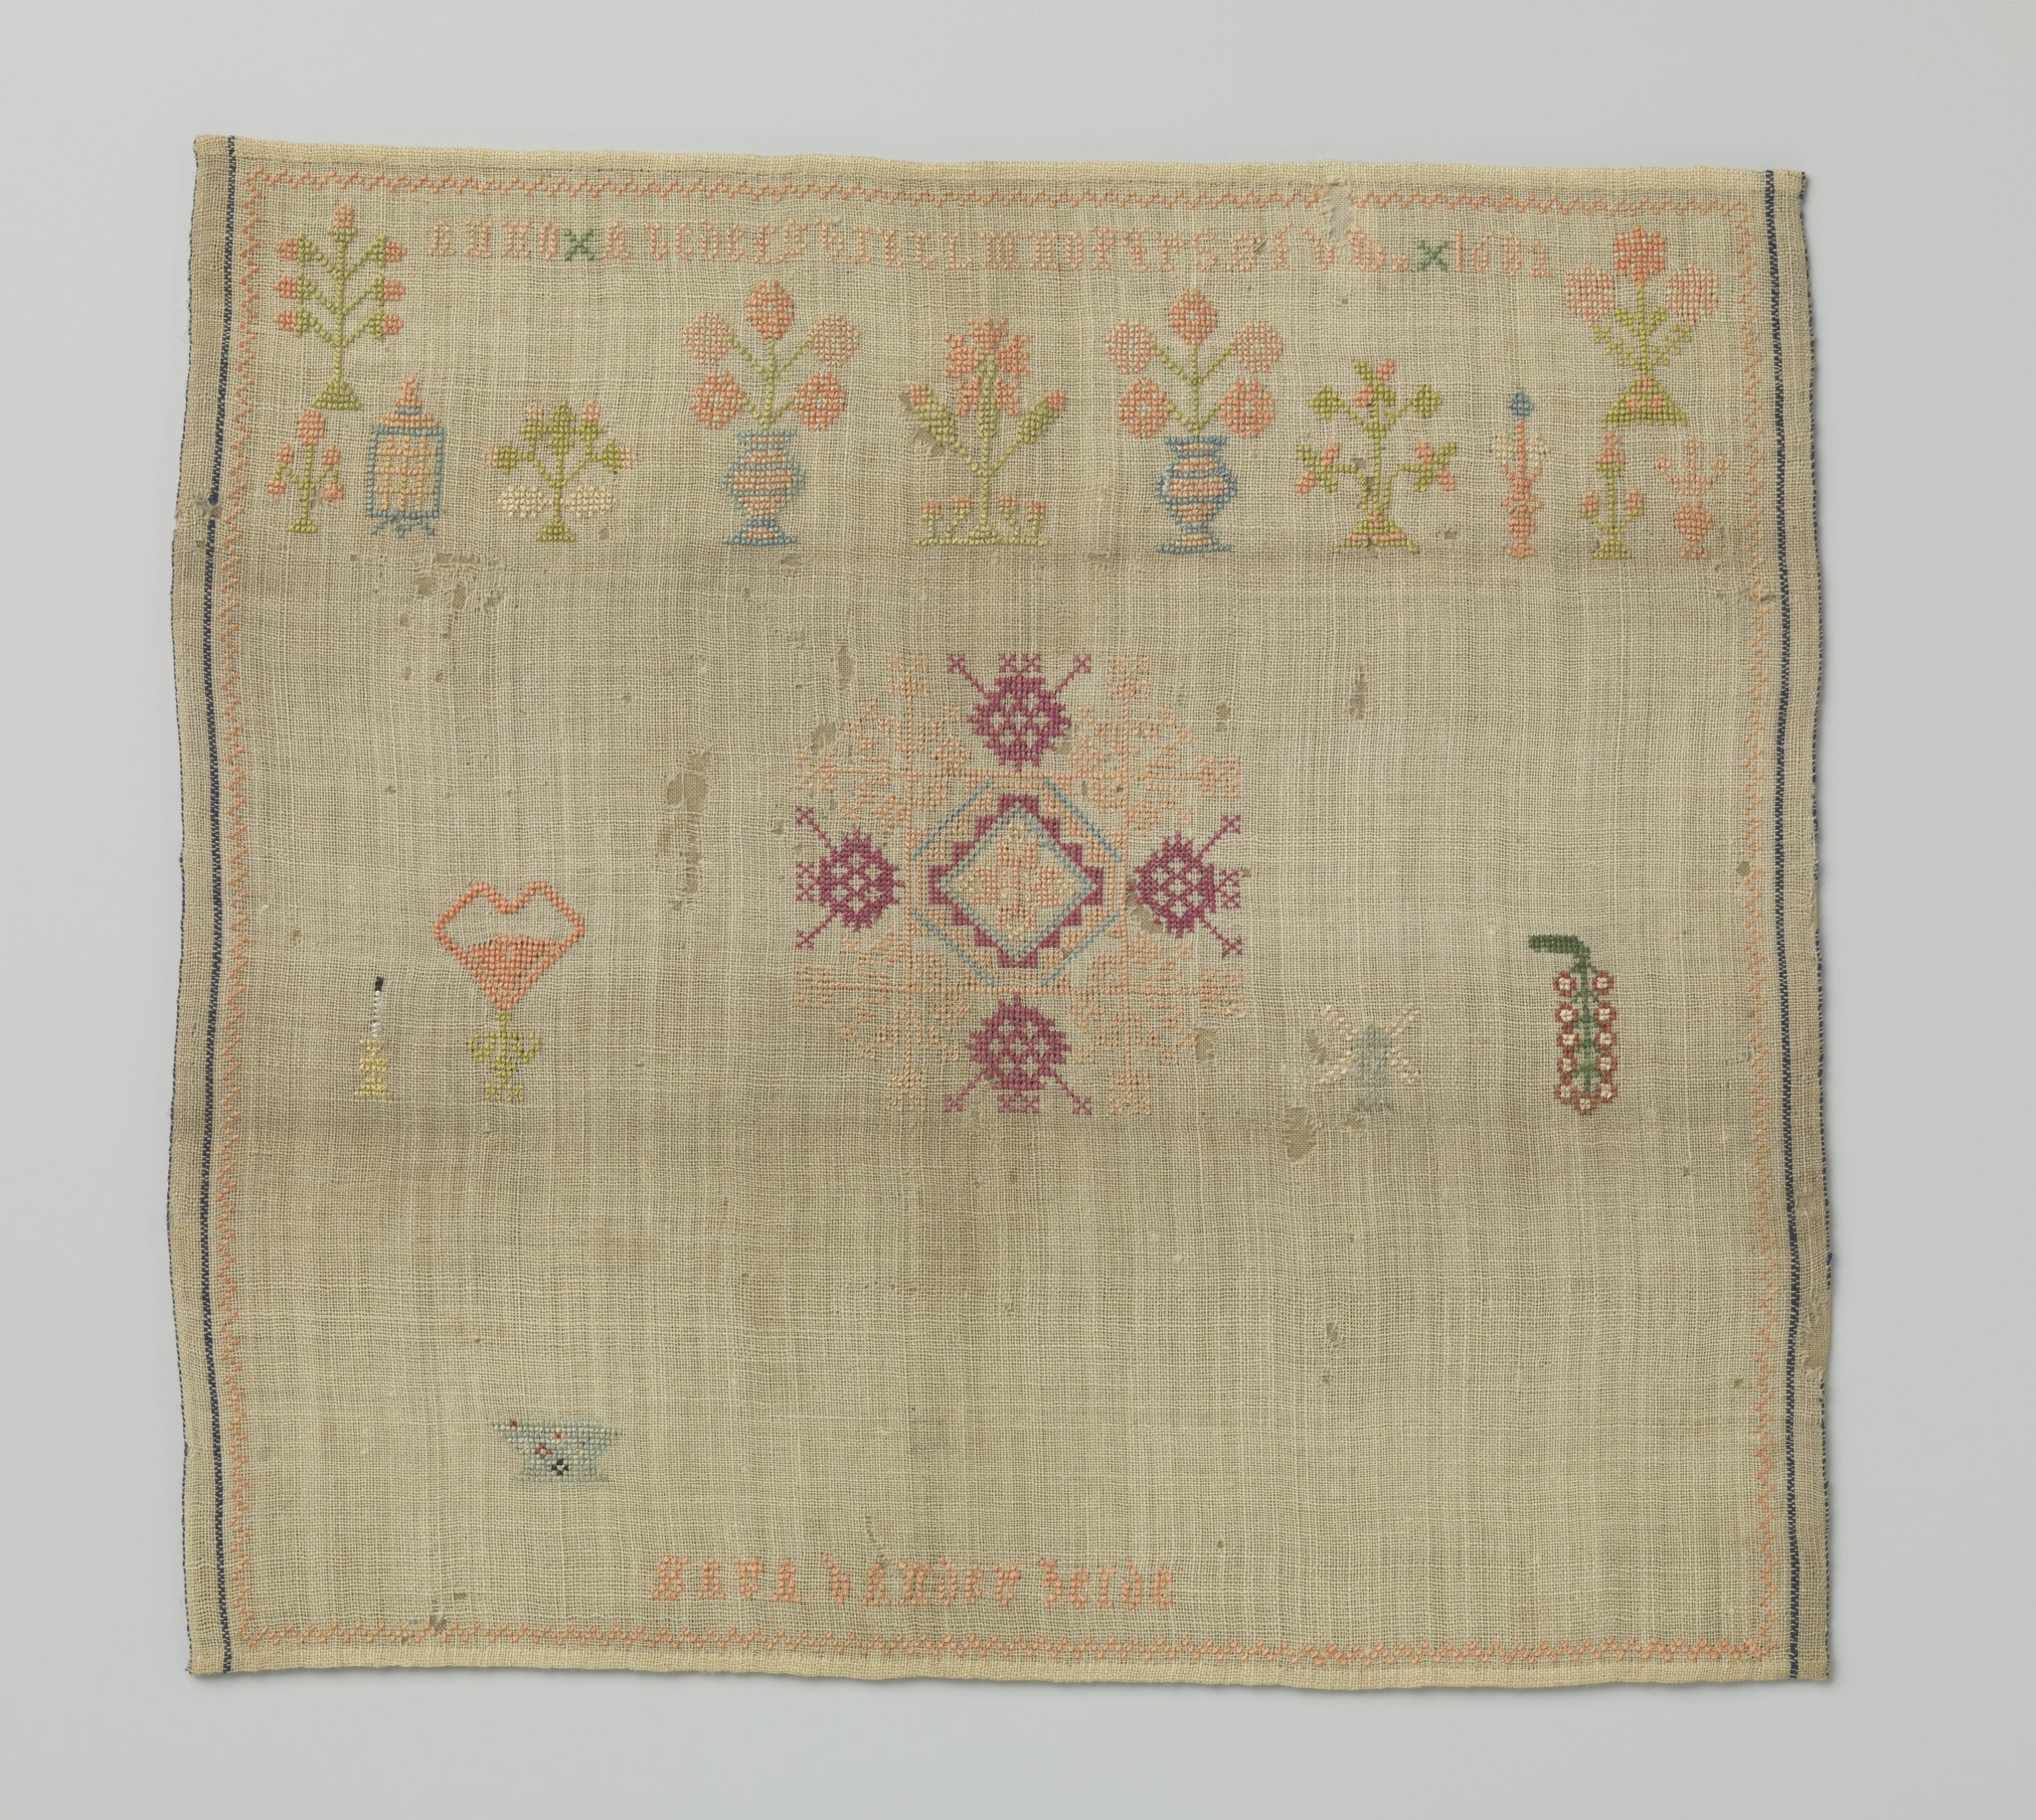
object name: merkdoek, merklap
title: Merklap van wollen mousseline waarop met zijde in kruissteken is geborduurd SARA VAN DER HEIDE en ANNO 1682, bloemen en vruchten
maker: sara van der heide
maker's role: borduurwerker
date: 1682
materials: silk, wool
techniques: embroidered, weave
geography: west frisia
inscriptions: signature and date: ‘ANNO 1682 SARA VAN DER HEIDE’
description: Indeling: in horizontale rijen maar niet voltooid. Opvallend is het gebruik van zalmrose zijde, een kleur die eveneens voor stoffen in de mode was. Het grote middenmotief vertoont vier grote violetkleurige granaatappels, geplaatst tegen het vierkant. De rijpe granaatappel laat vele zaden zien en de vrucht werd daarom het symbool van de vruchtbaarheid.